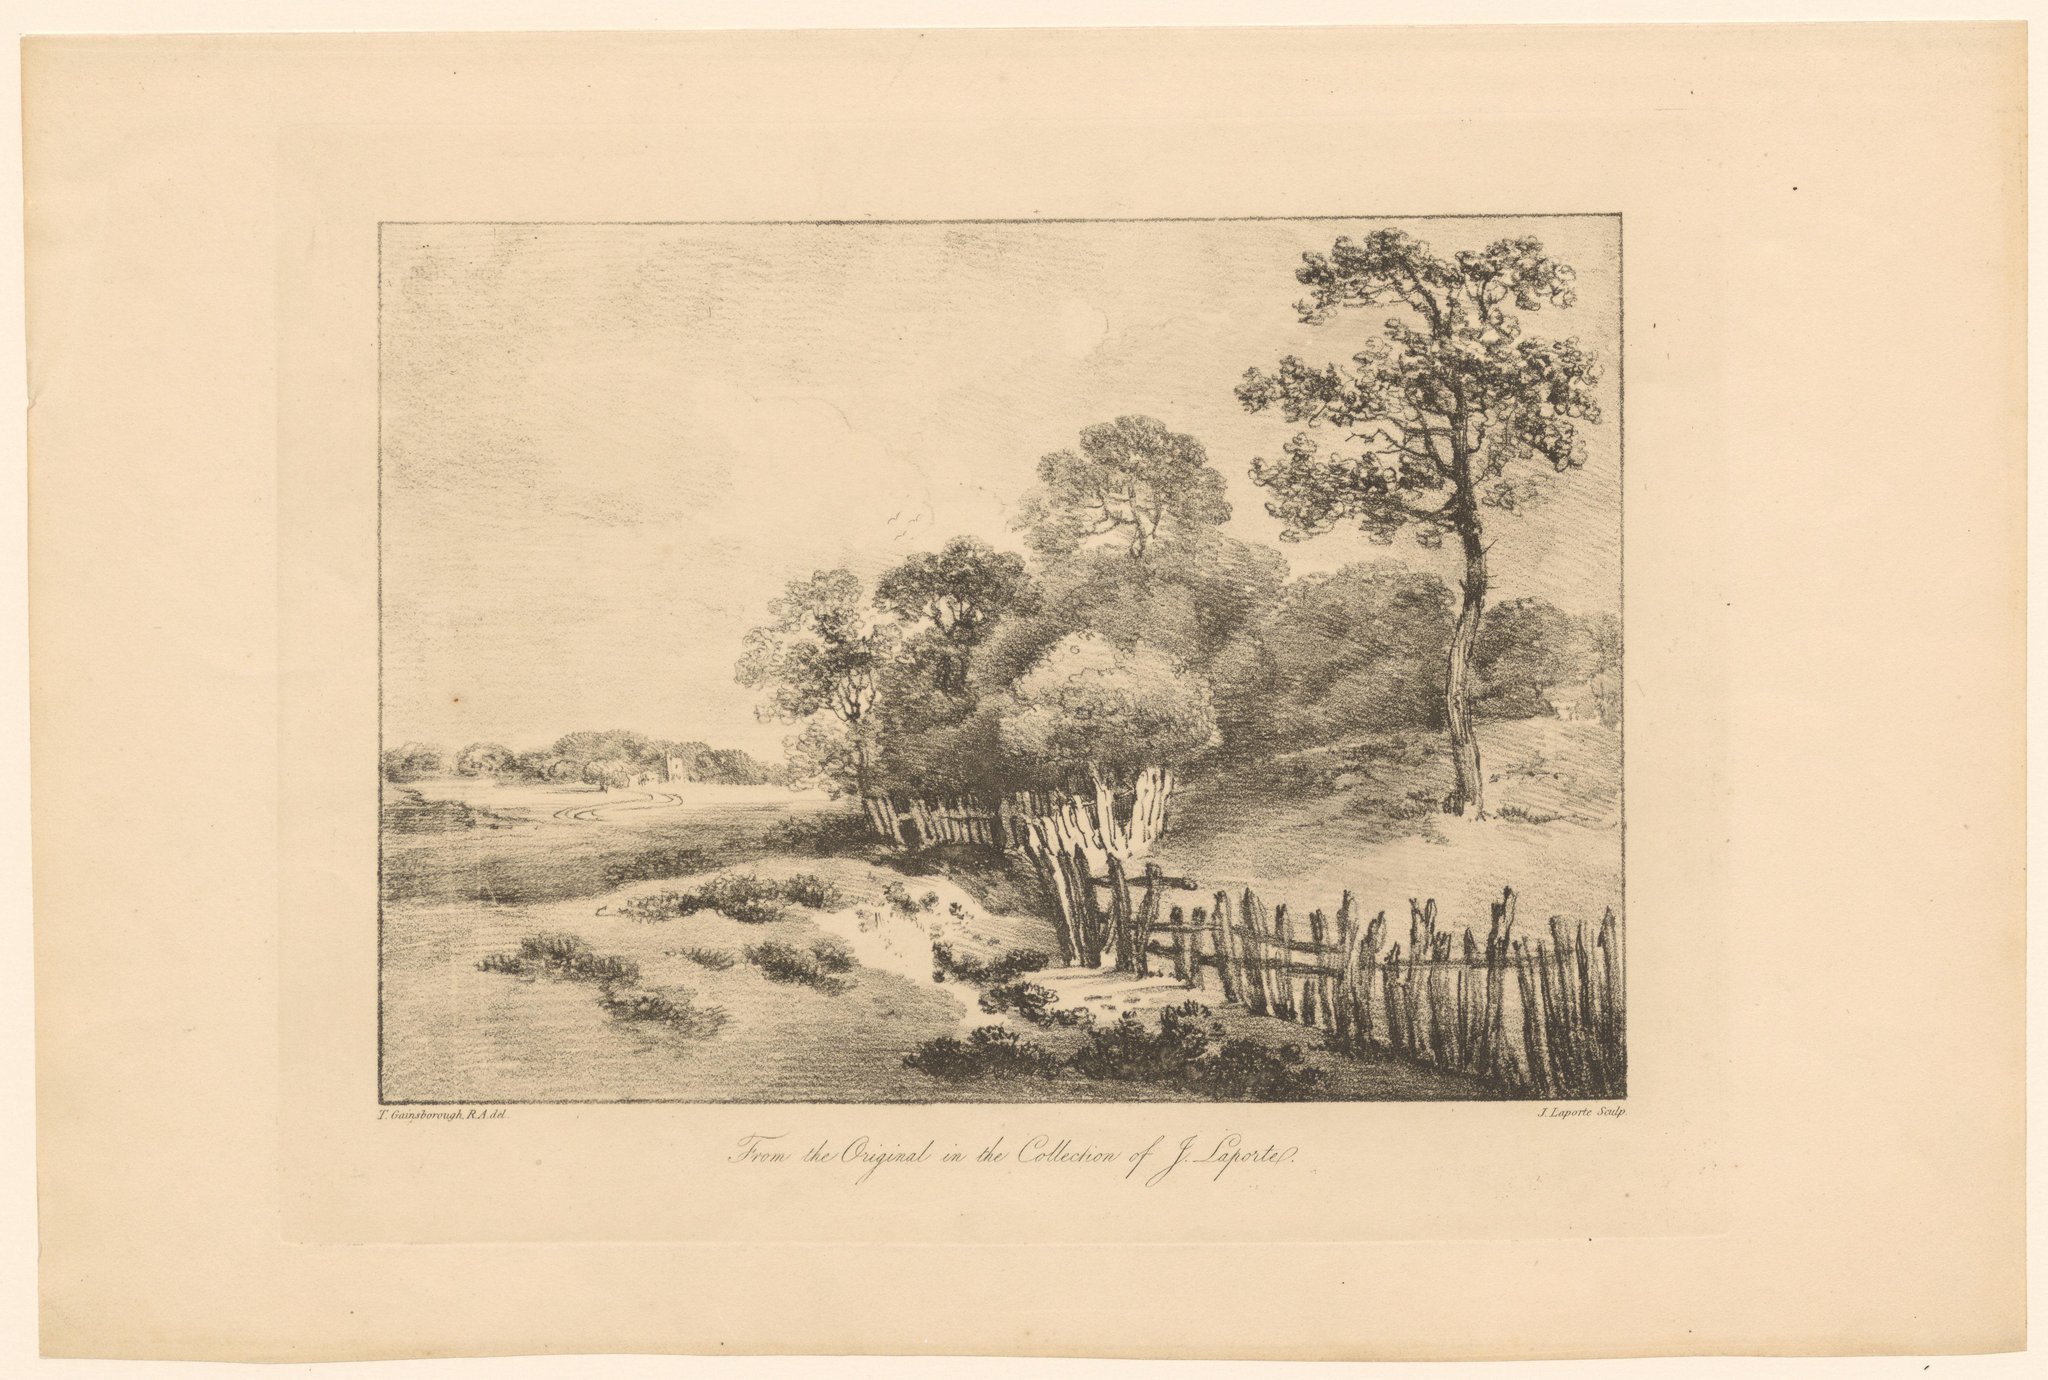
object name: print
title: Landschap met een hekwerk aan een bosrand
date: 1771-1839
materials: paper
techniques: soft ground etching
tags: fence, wall, paling, meadow, pasture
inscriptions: collector's mark: Lugt 2228